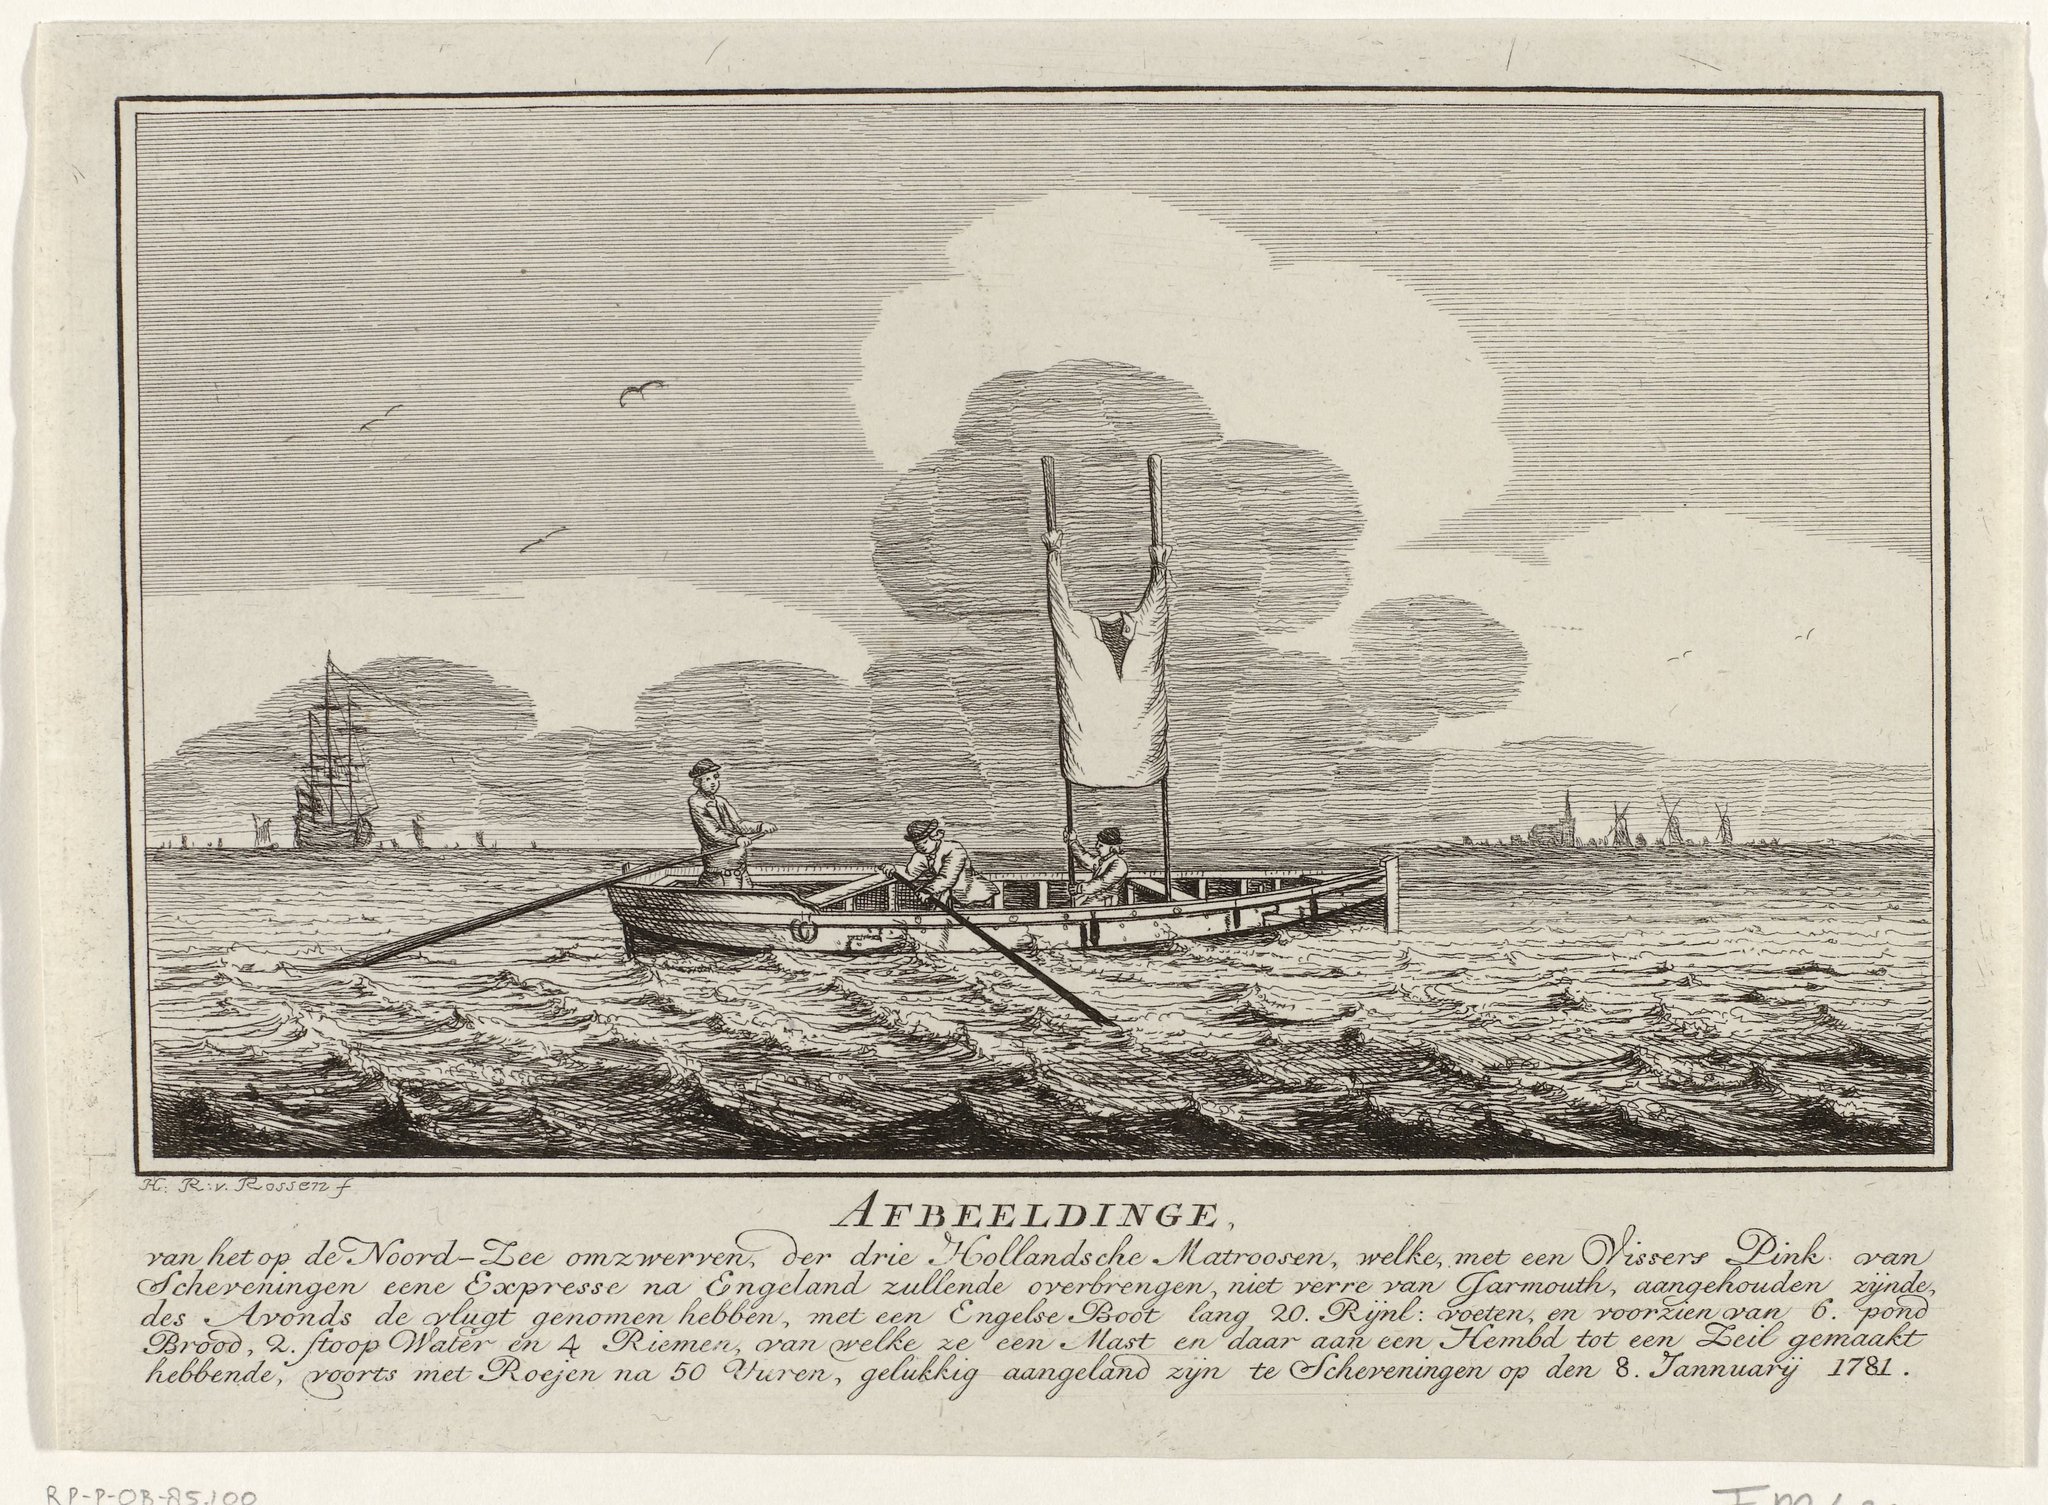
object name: print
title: Afbeeldinge, van het op de Noord-Zee omzwerven, der drie Hollandsche Matroosen (...) gelukkig aangeland te Scheveningen 8 Jannuarij 1781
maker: hendrik r. van rossen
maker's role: print maker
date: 1781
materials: paper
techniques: etching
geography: northern netherlands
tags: escape, escape attempts, rowing-boat, canoe, etc., fourth anglo-dutch war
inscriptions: collector's mark: Lugt 2228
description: De aankomst van drie uit Engeland gevluchte Hollandse matrozen bij de kust bij Scheveningen op 8 januari 1781. De matrozen ontvluchtten aanhouding in Yarmouth en roeiden in een visserspink terug naar Nederland.